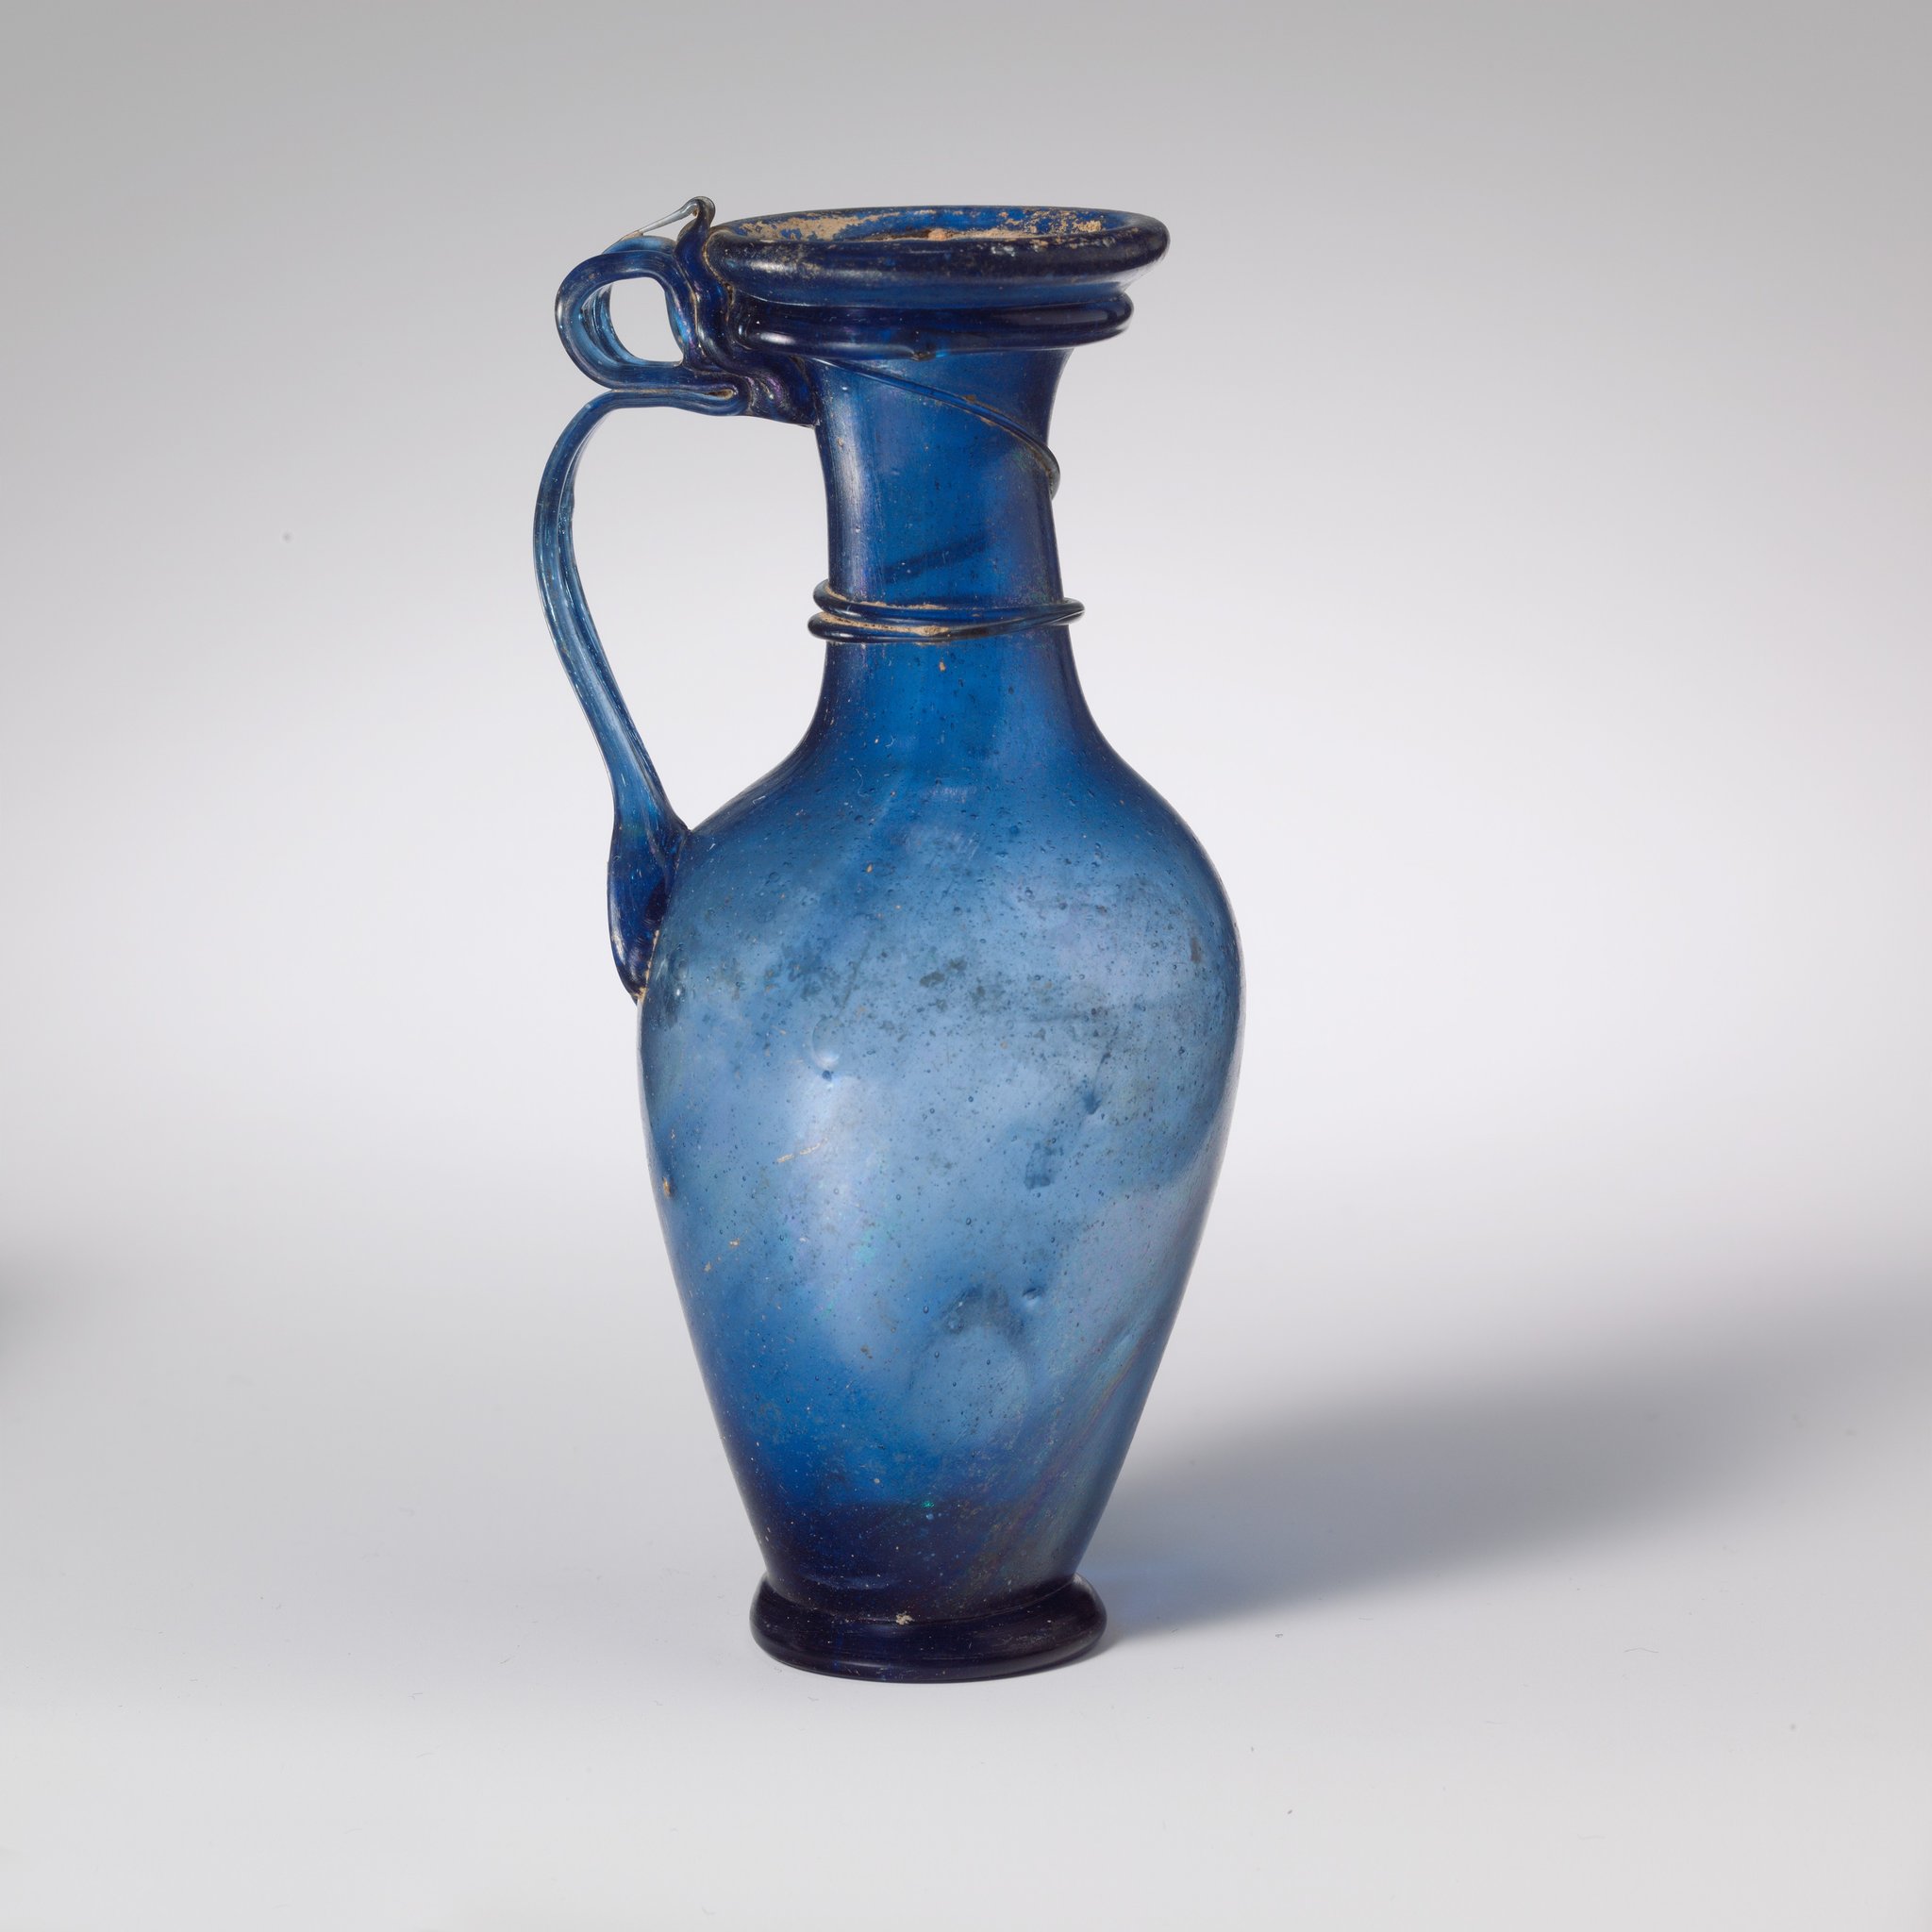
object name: jug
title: Glass jug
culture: roman, rhenish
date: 201-400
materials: glass